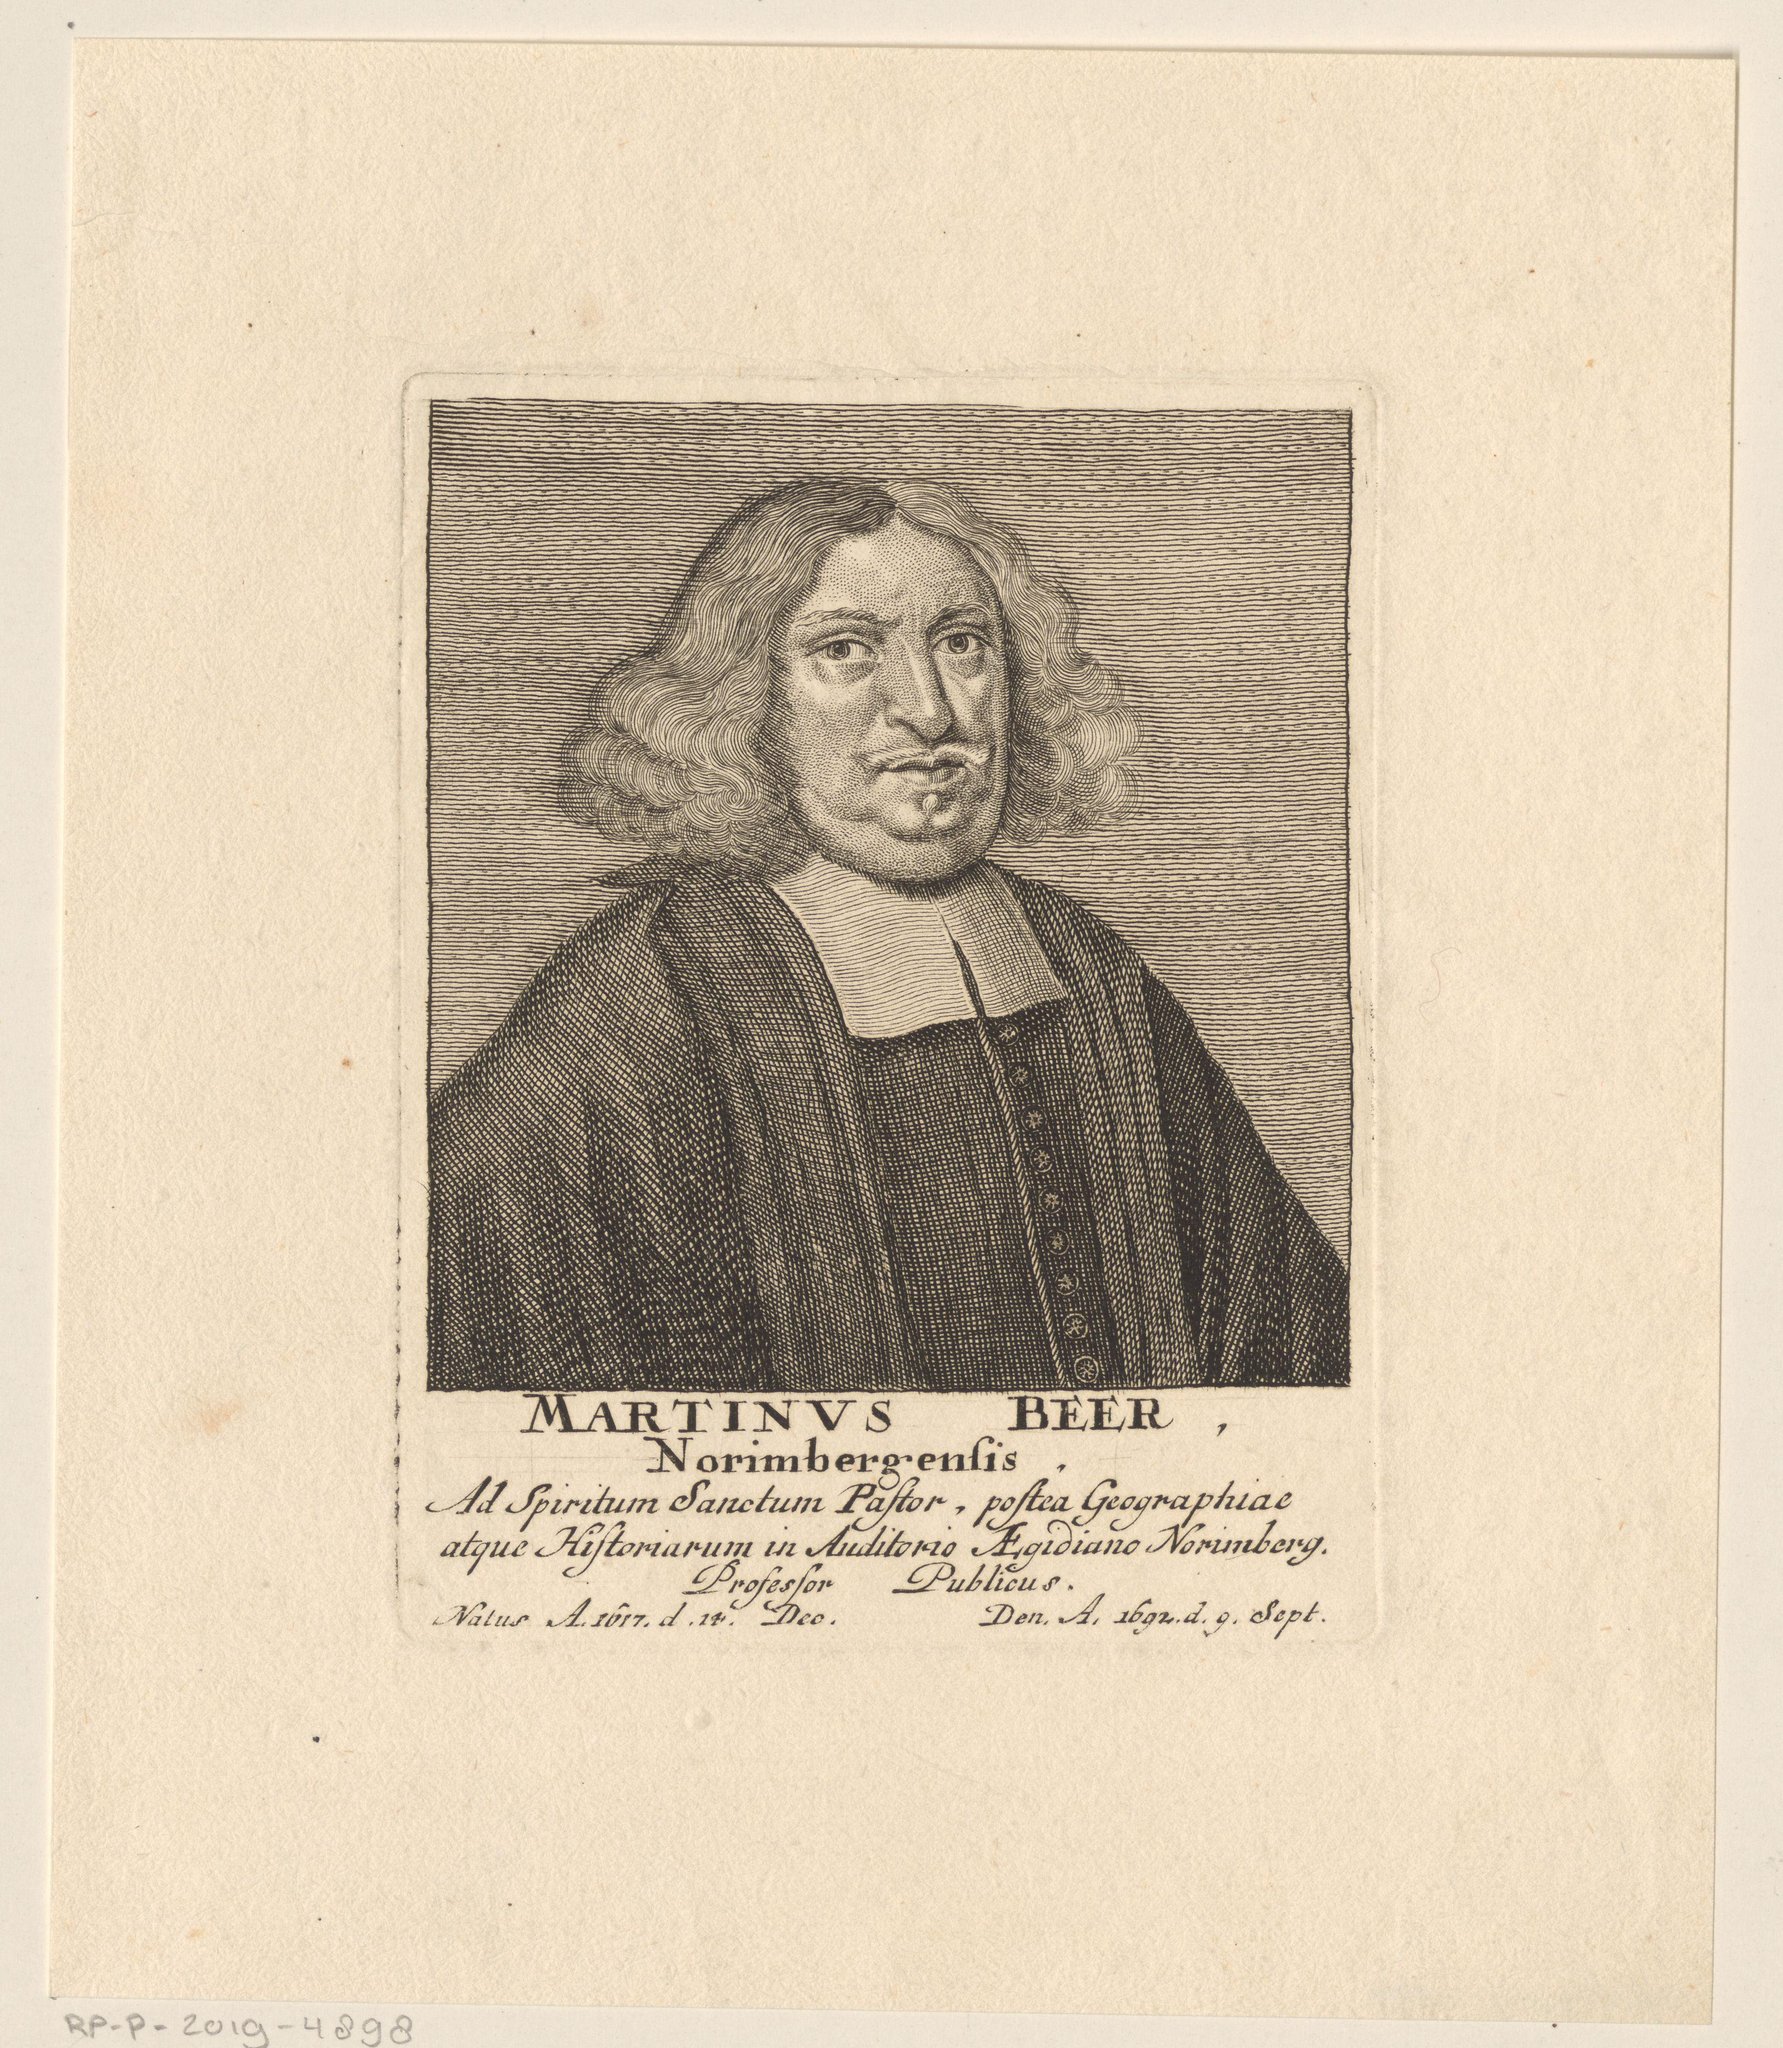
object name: print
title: Icones virorum omnium ordinum eruditione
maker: Anonymous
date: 1725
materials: paper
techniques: engraving, etching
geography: nuremberg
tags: theologian, historical persons